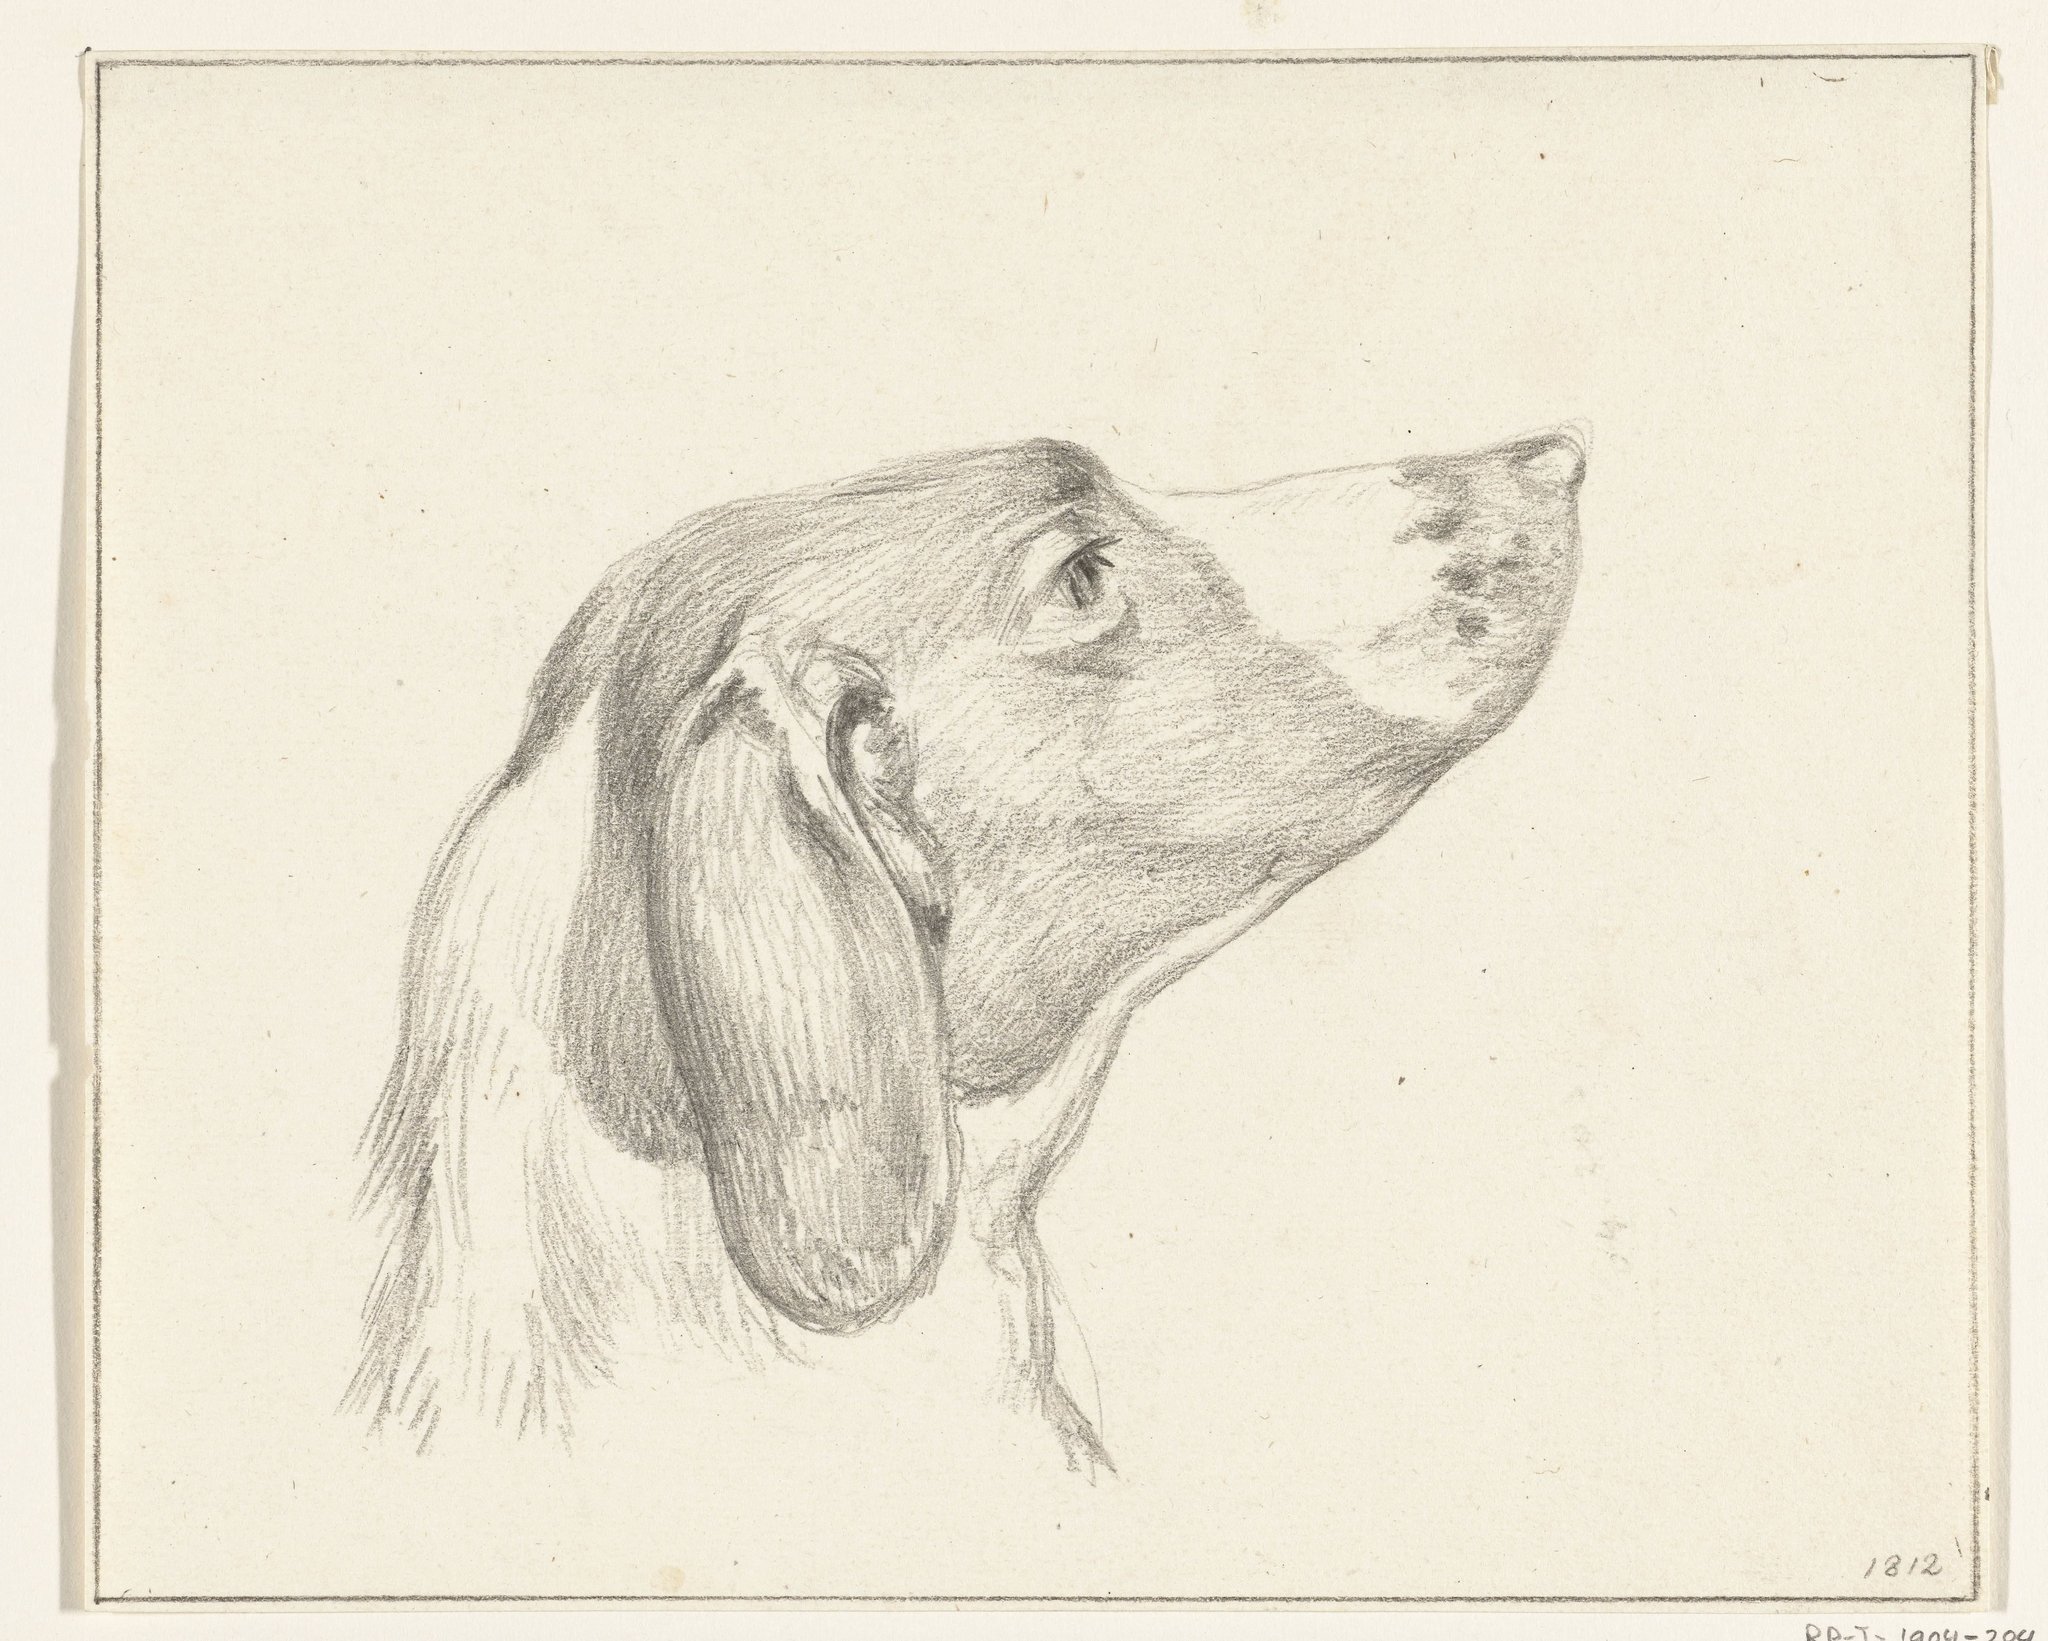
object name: drawing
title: Kop van een hond, naar rechts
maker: jean bernard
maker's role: draughtsman, print maker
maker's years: 1765-1833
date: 1812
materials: chalk, paper, pencil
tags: dog